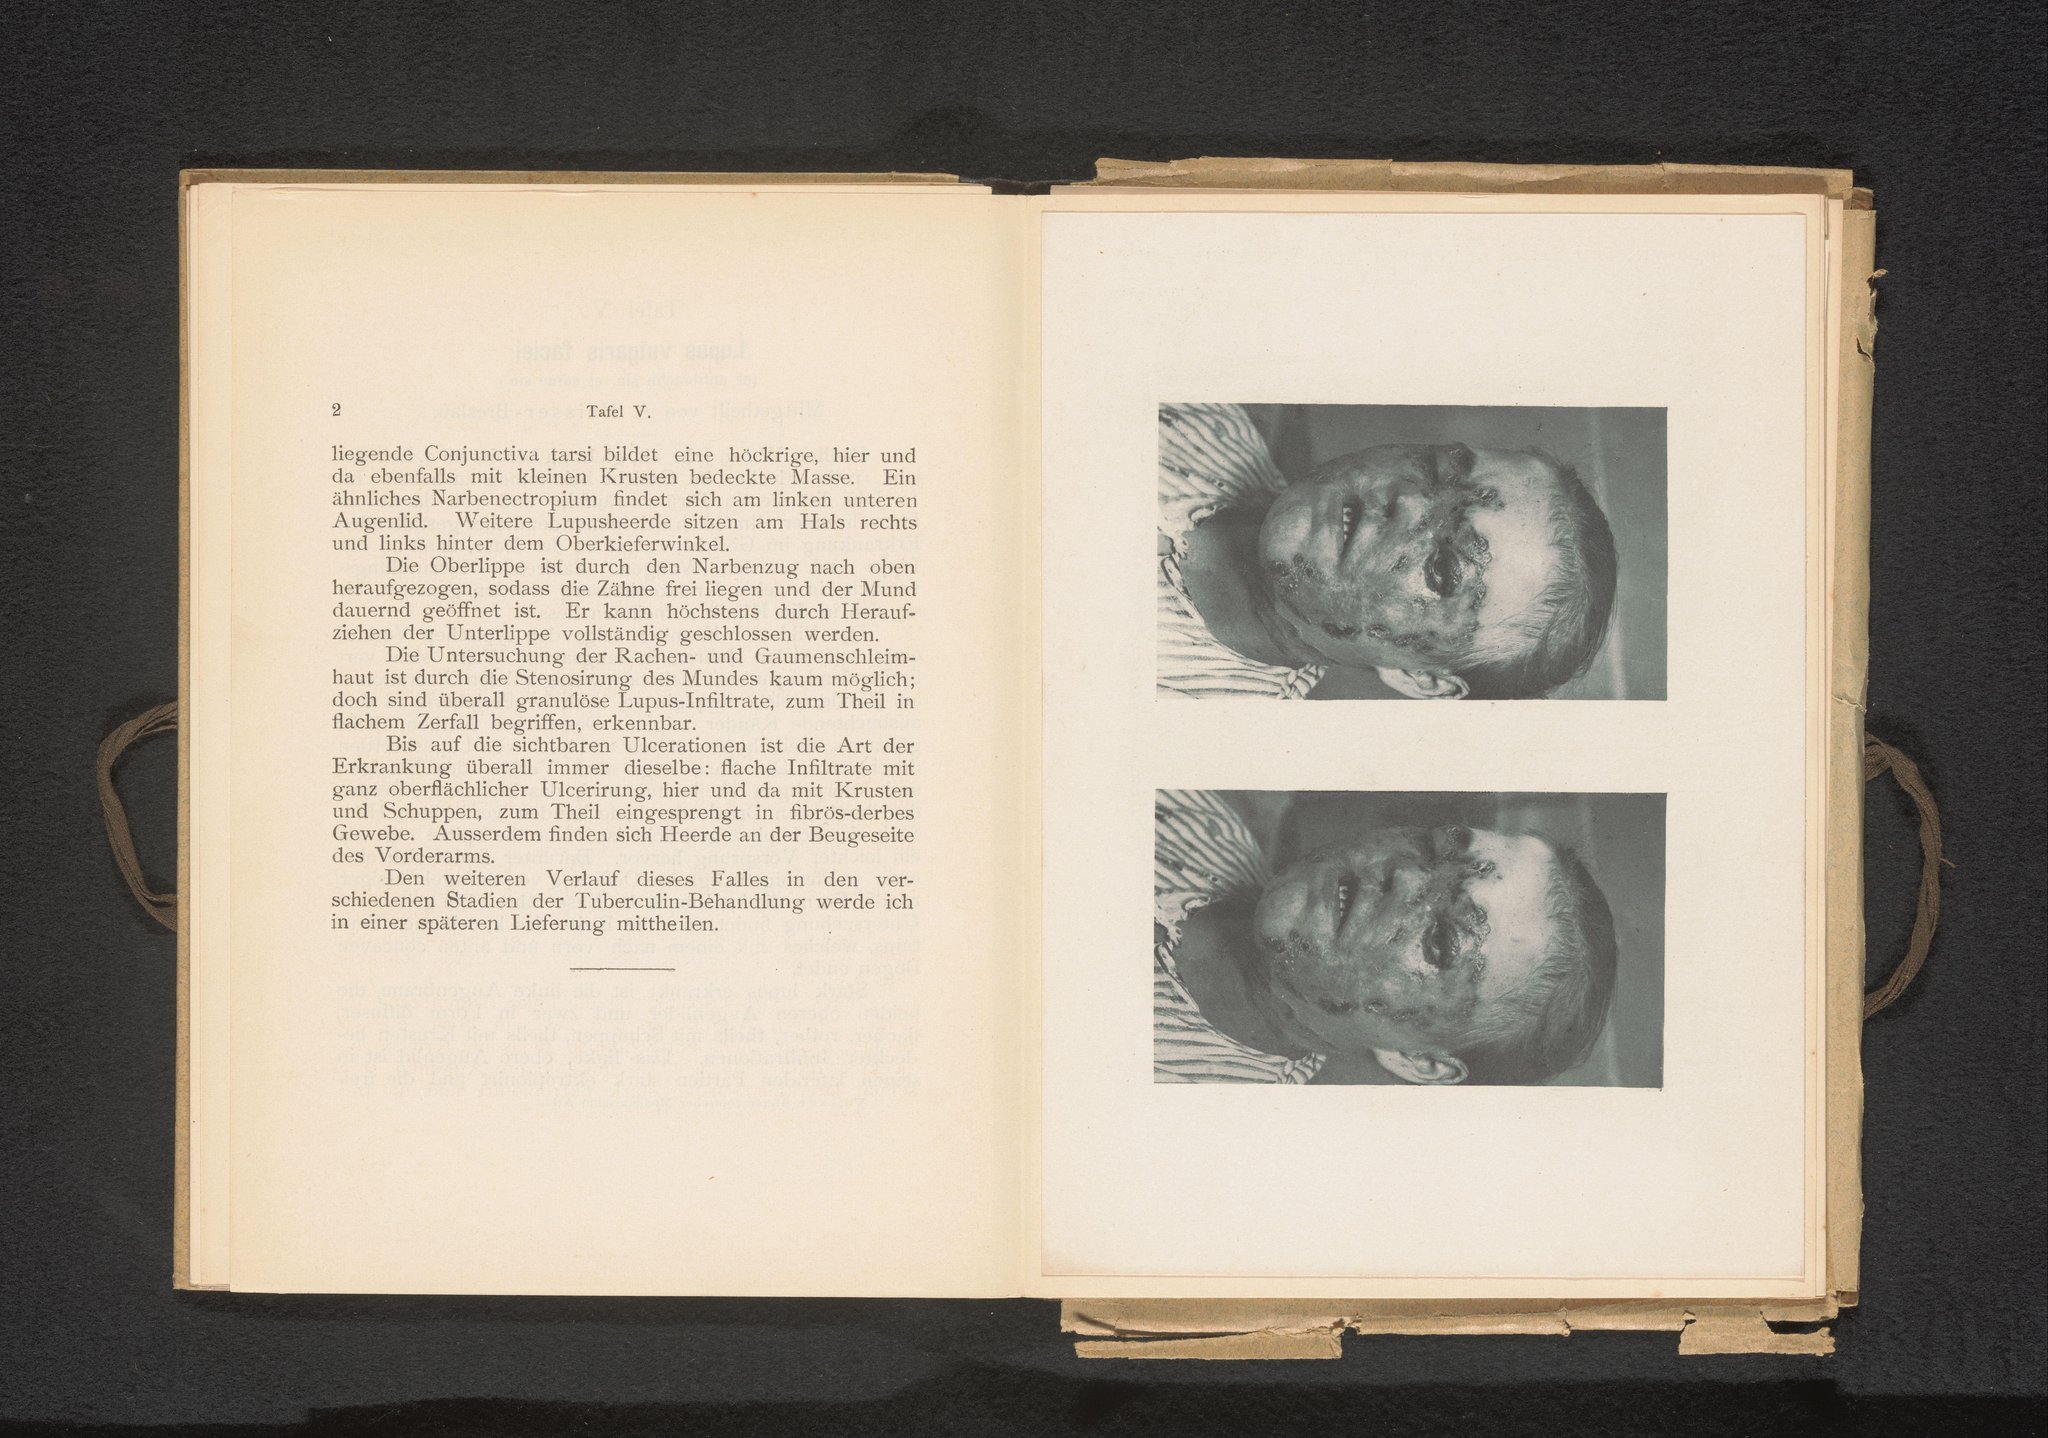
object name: stereograph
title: Twee portretten van een patiënt met symptomen van huidtuberculose aan het gezicht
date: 1884-1894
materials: paper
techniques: photoaquatint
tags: skin and venereal diseases, patient, sick person